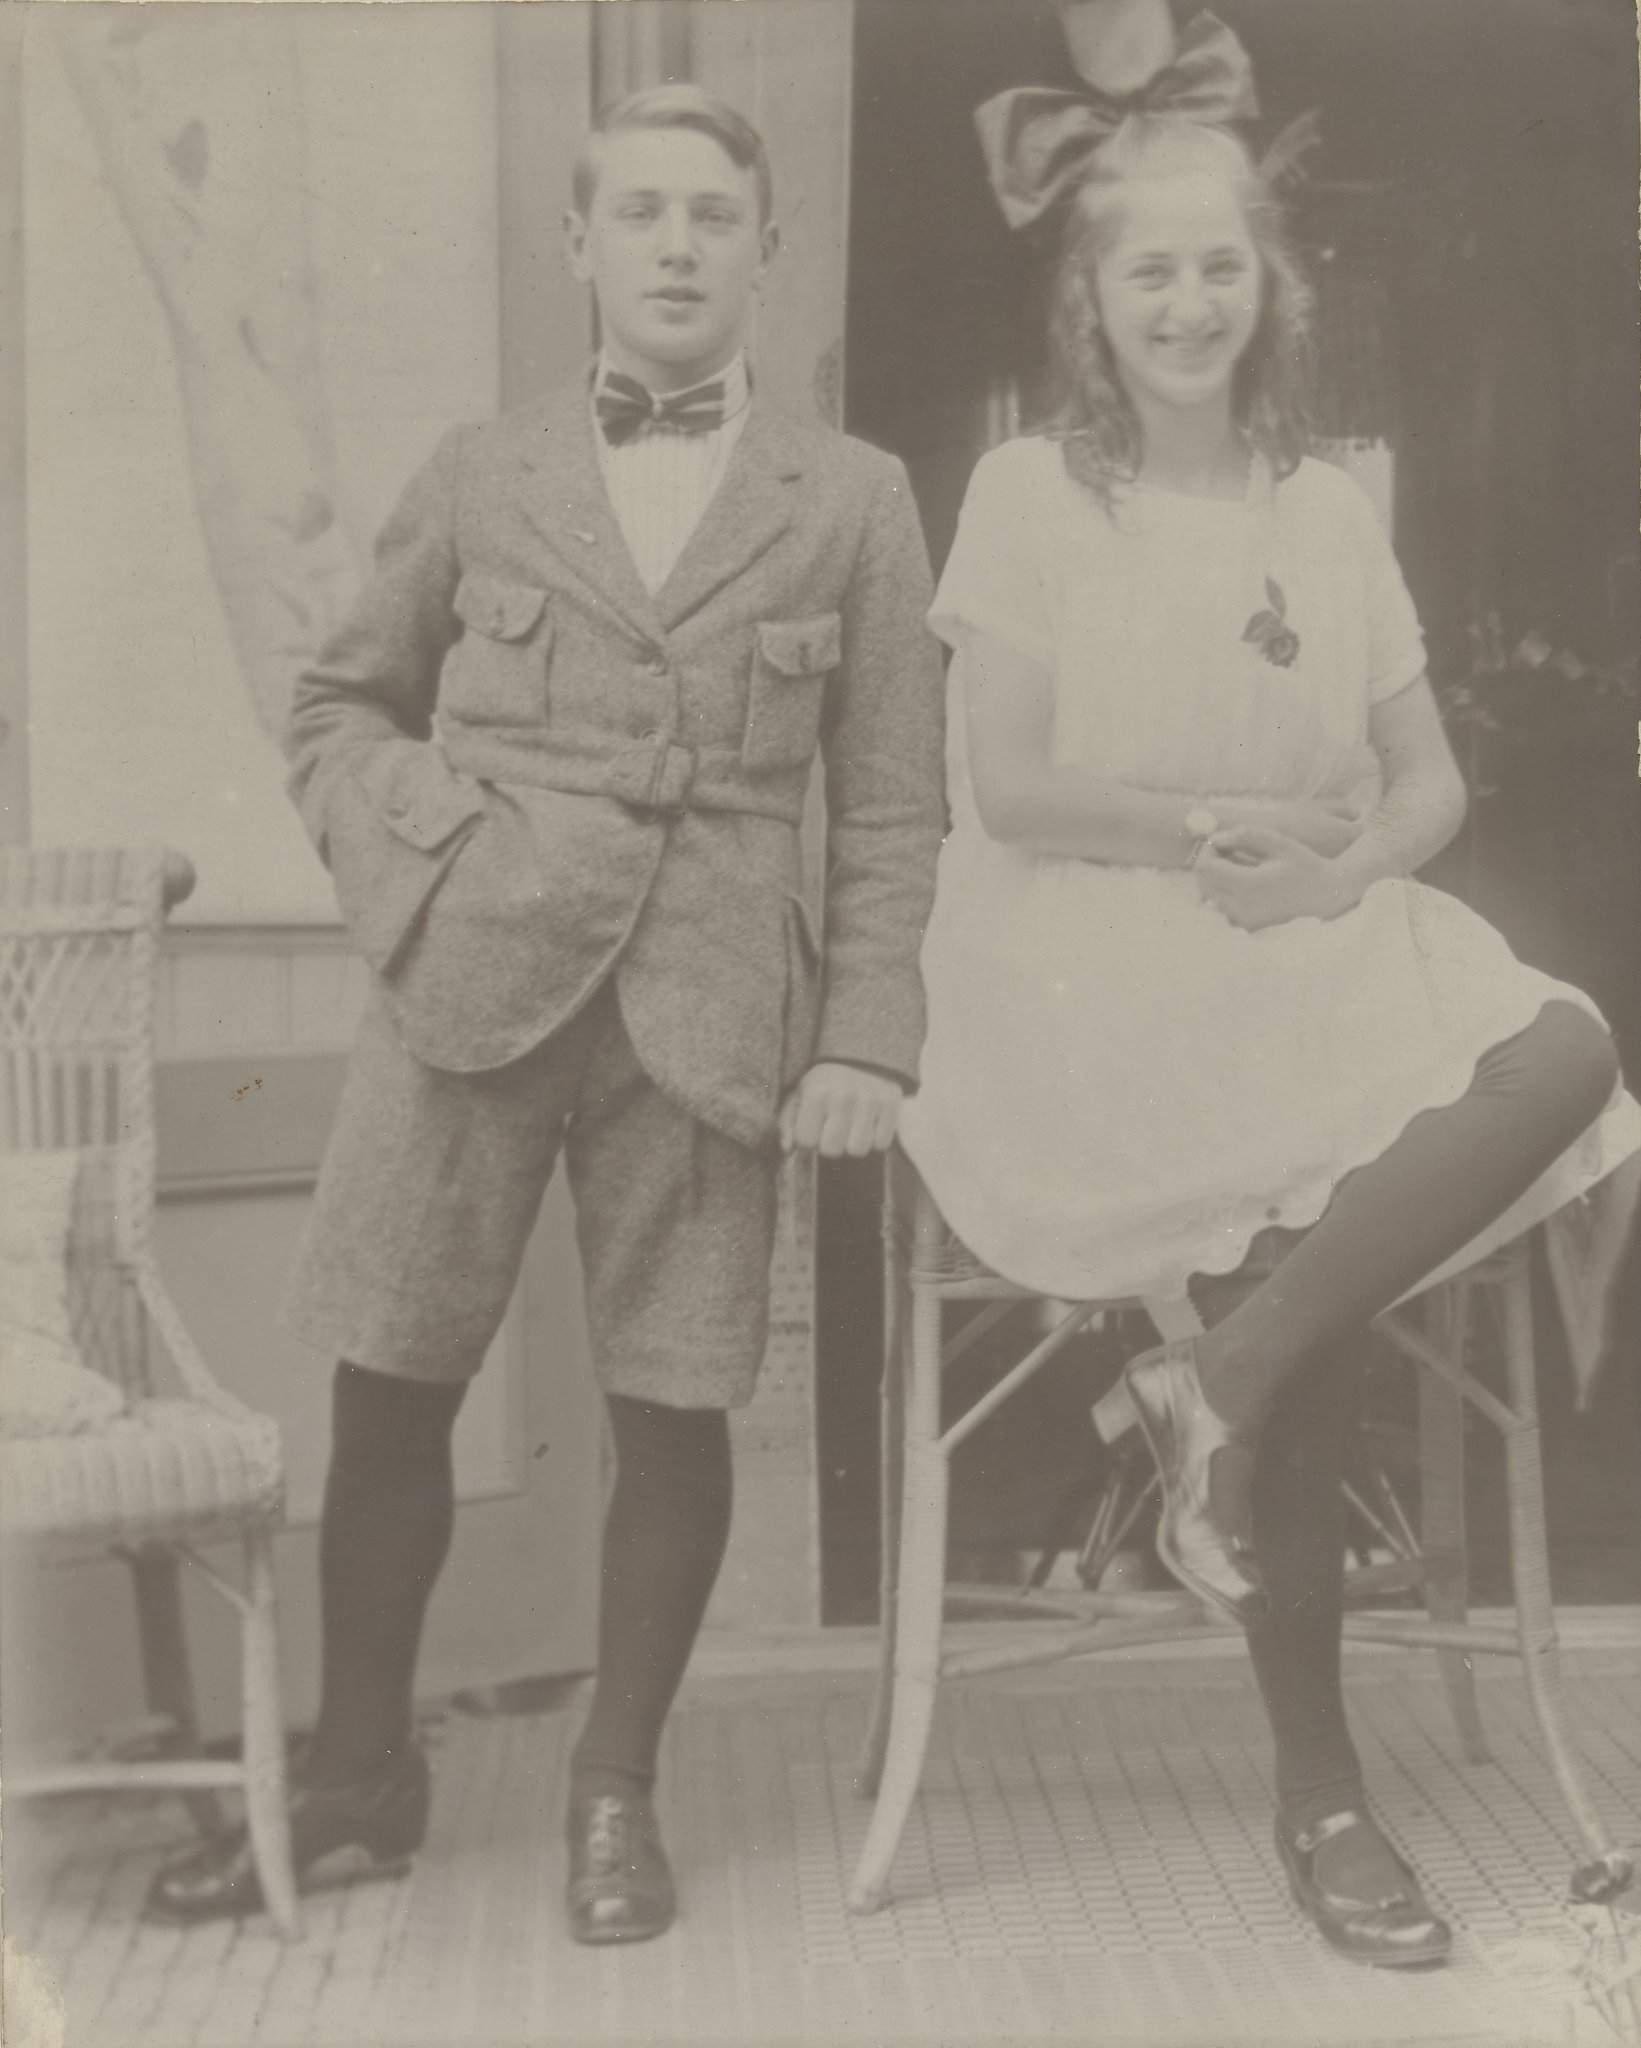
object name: photograph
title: Portret van een meisje met strik en een jongen die naast haar staat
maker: Anonymous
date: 1910-1930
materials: photographic support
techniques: photography